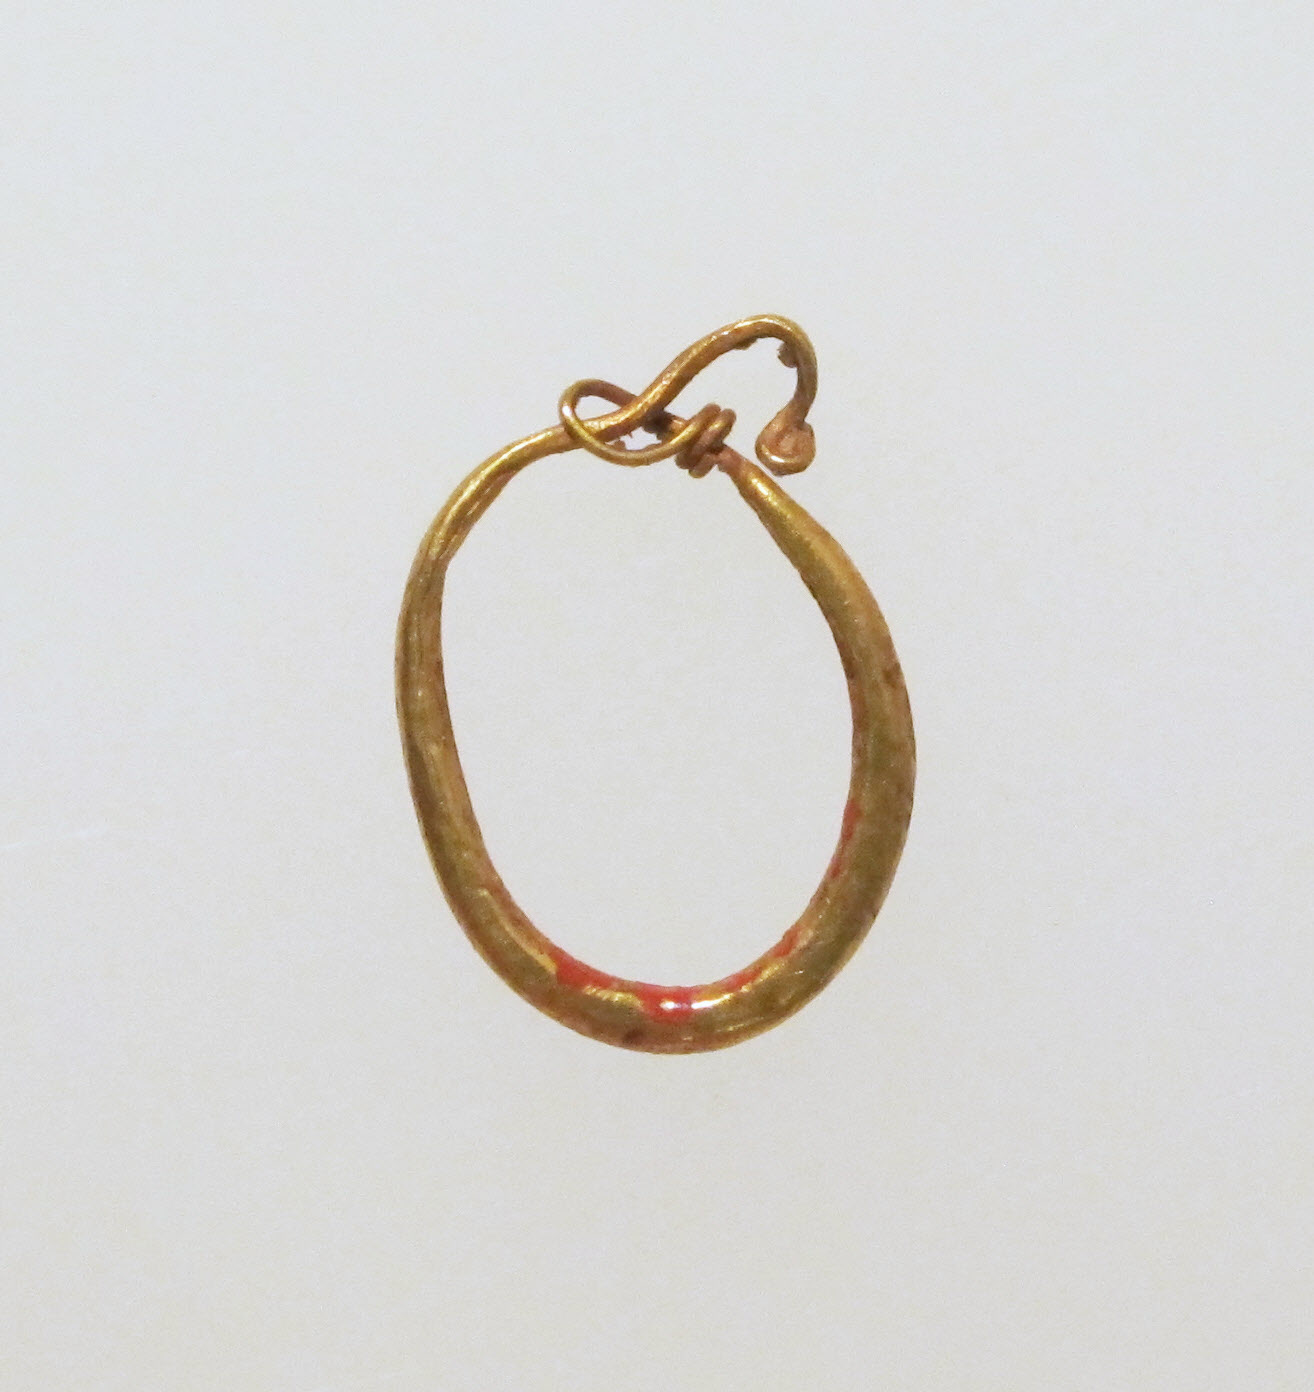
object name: earring loop type, plain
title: Earring-loop type, plain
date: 7000 BCE-330 CE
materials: gold